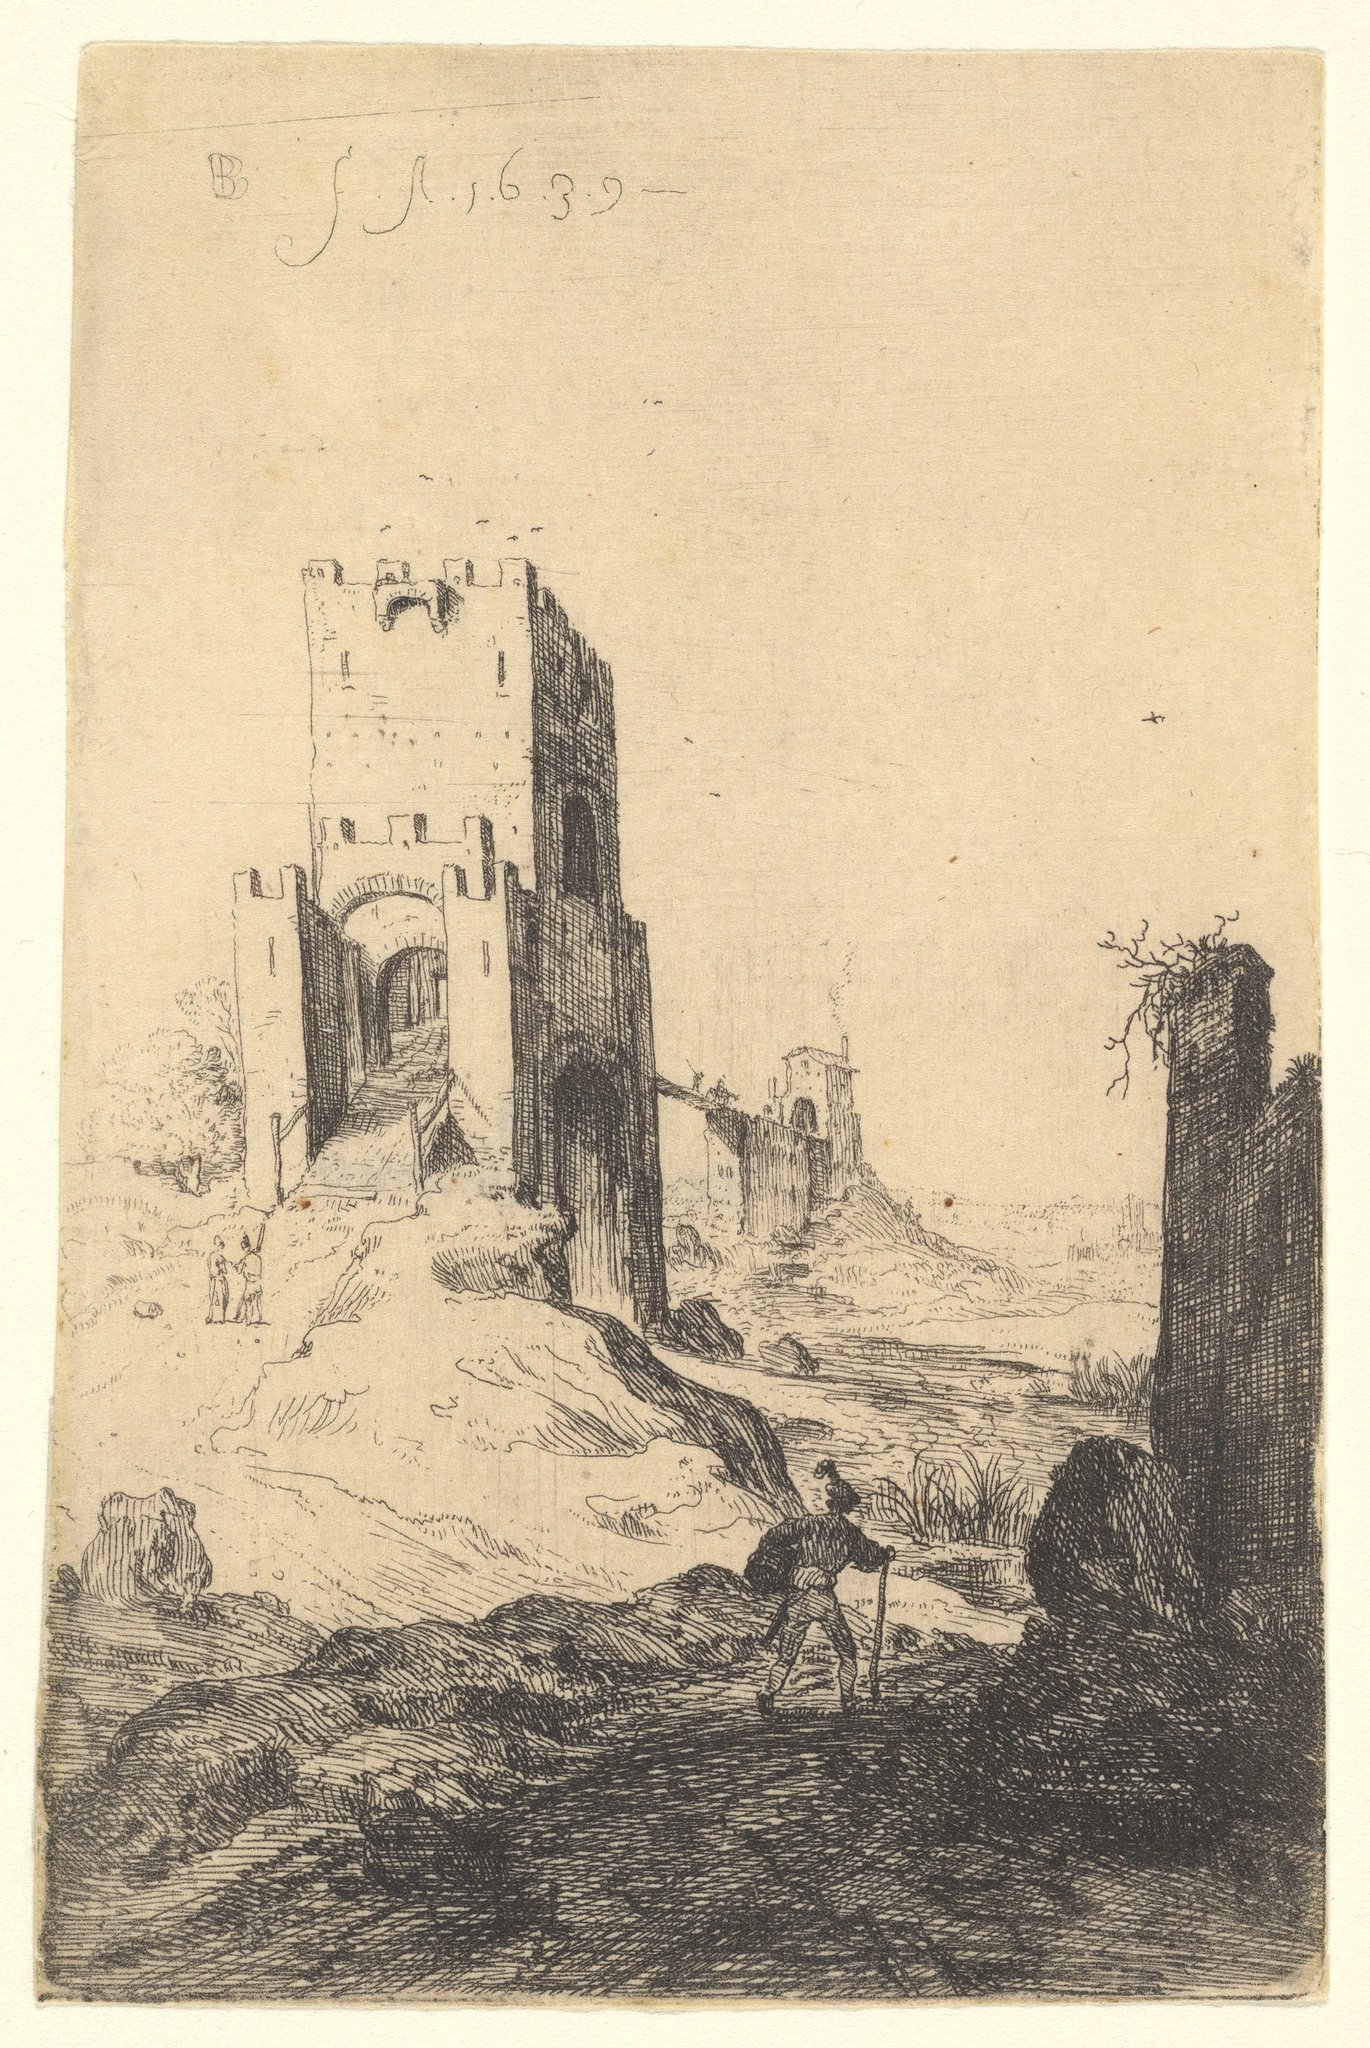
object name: print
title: View of Ponte Mammolo, from "The Ruins of Rome"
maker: bartholomeus breenbergh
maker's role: artist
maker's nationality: dutch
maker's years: 1598-1657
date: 1639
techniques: etching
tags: towers,bridges,men,walking